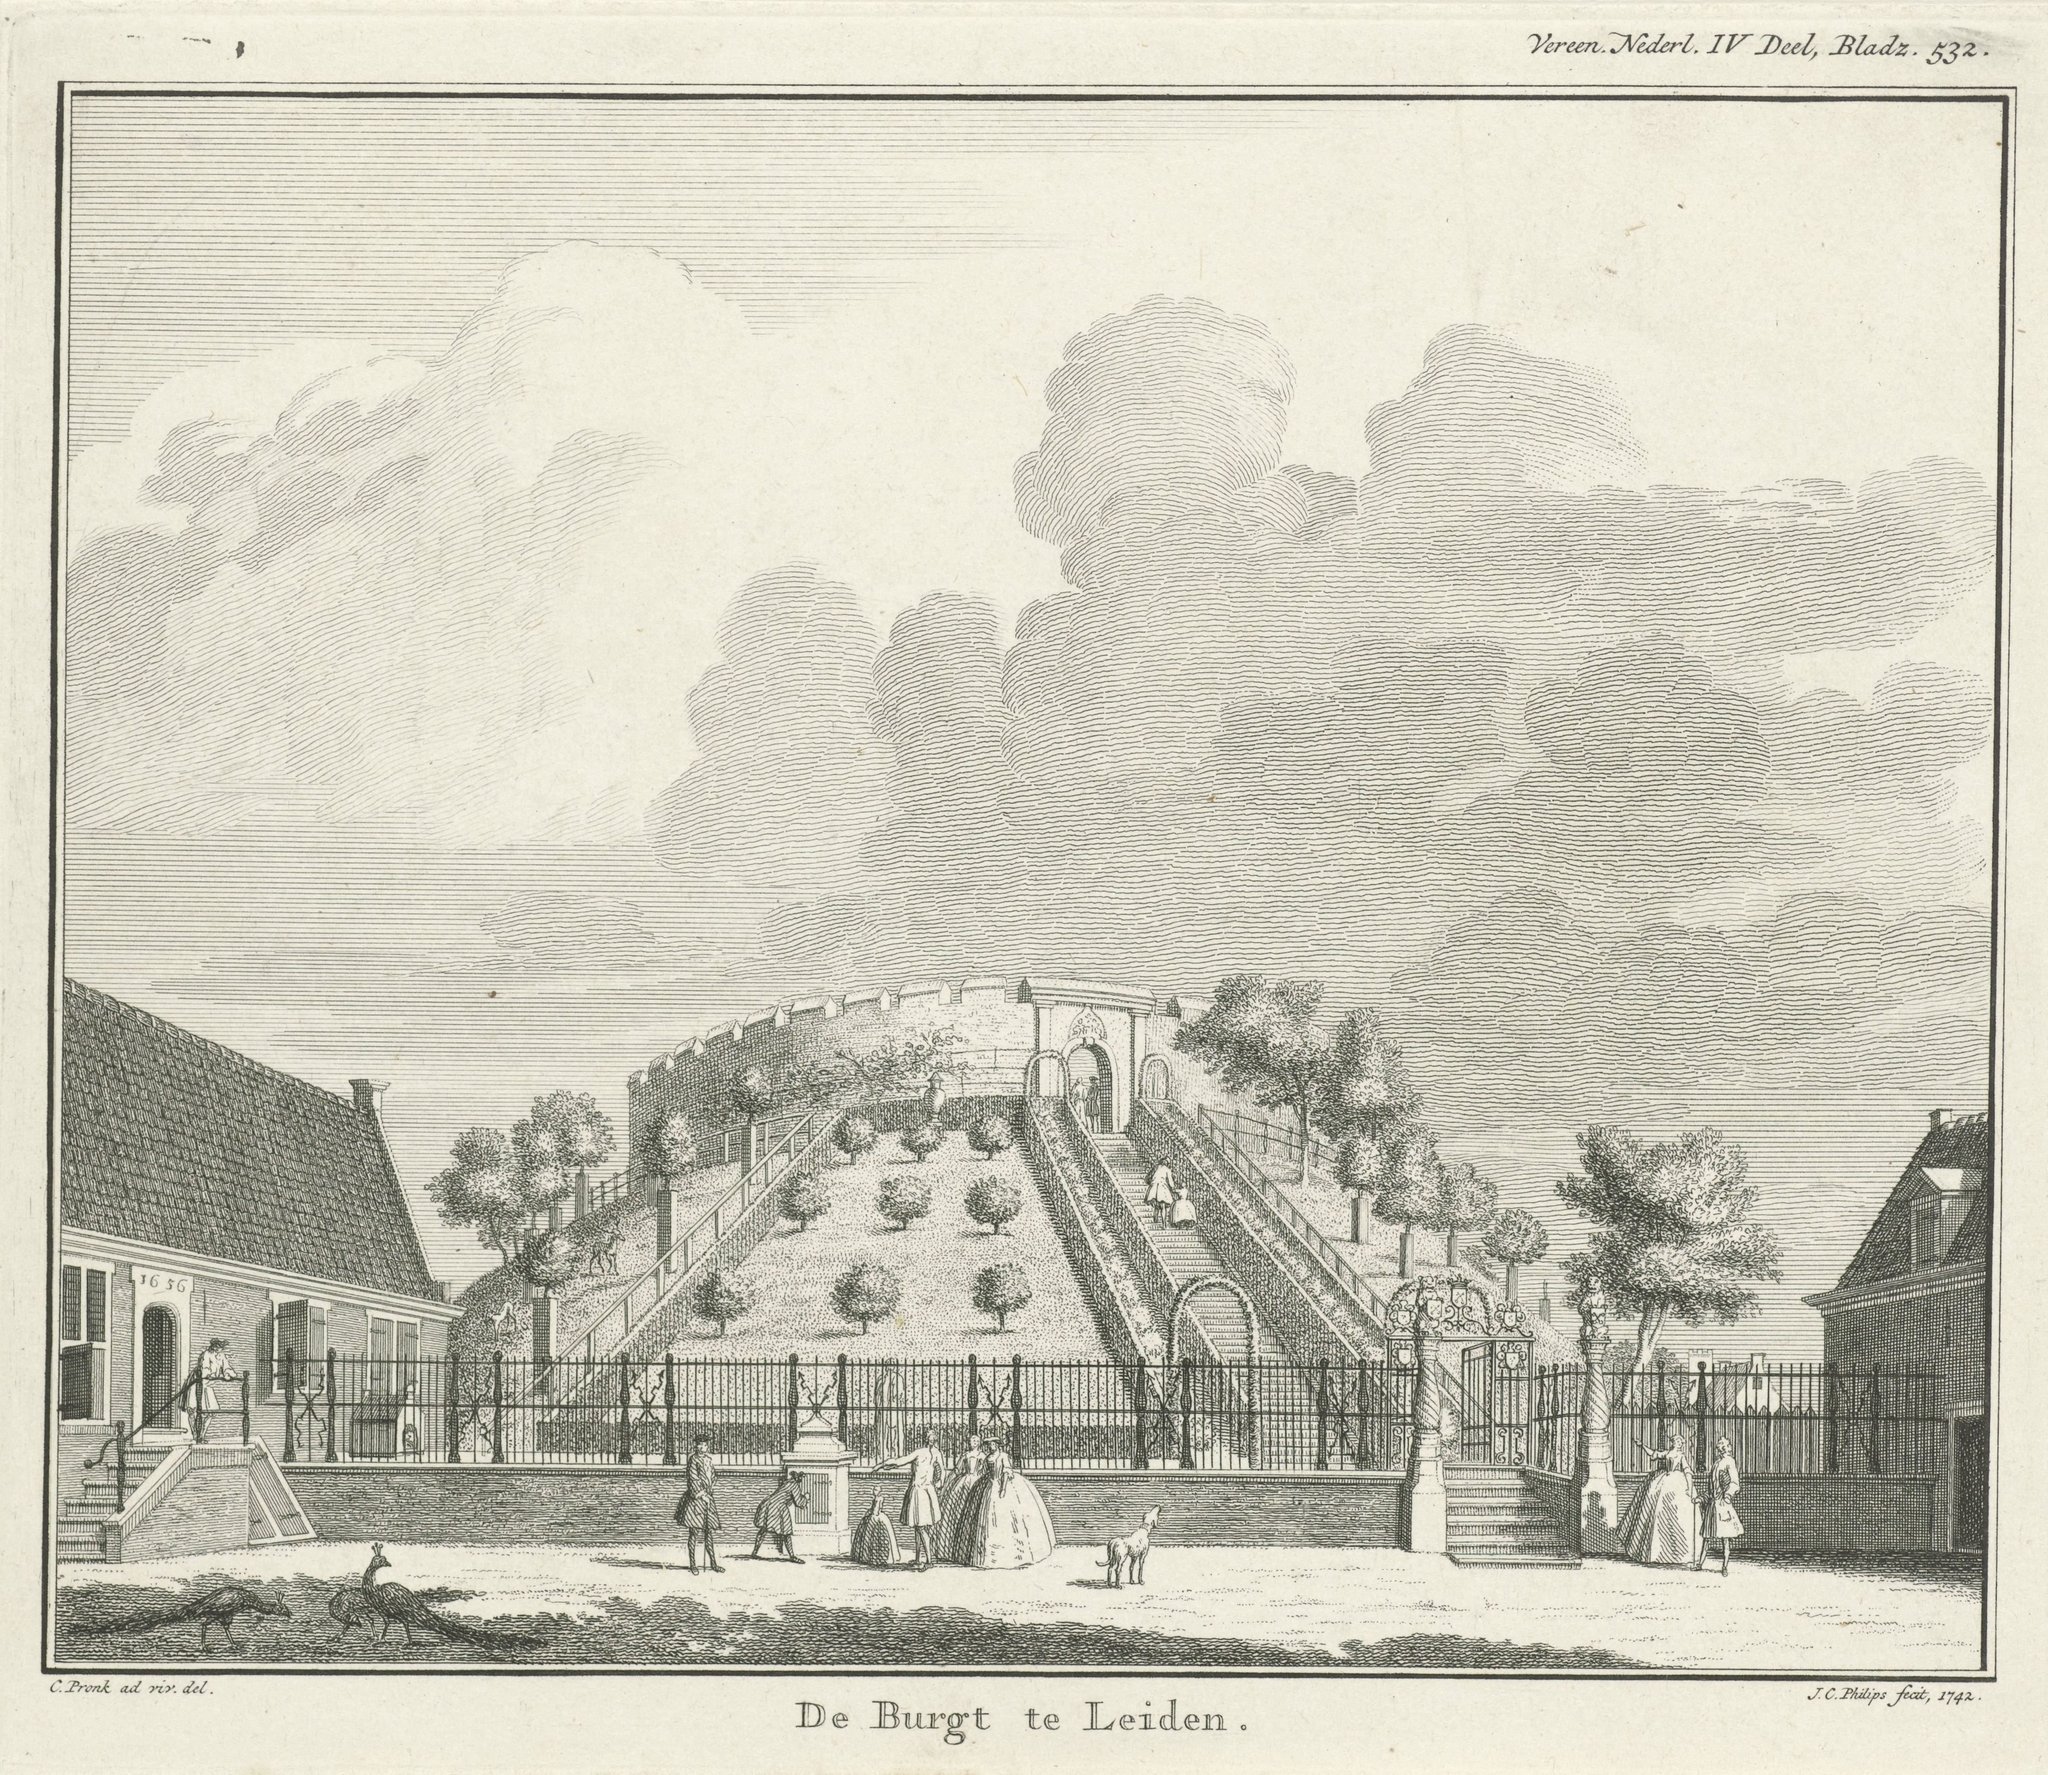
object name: print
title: De burgt te Leiden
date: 1742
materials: paper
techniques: etching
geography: amsterdam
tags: fortress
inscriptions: collector's mark: Lugt 2228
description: Gezicht op de burcht van Leiden, met op de voorgrond enkele figuren.